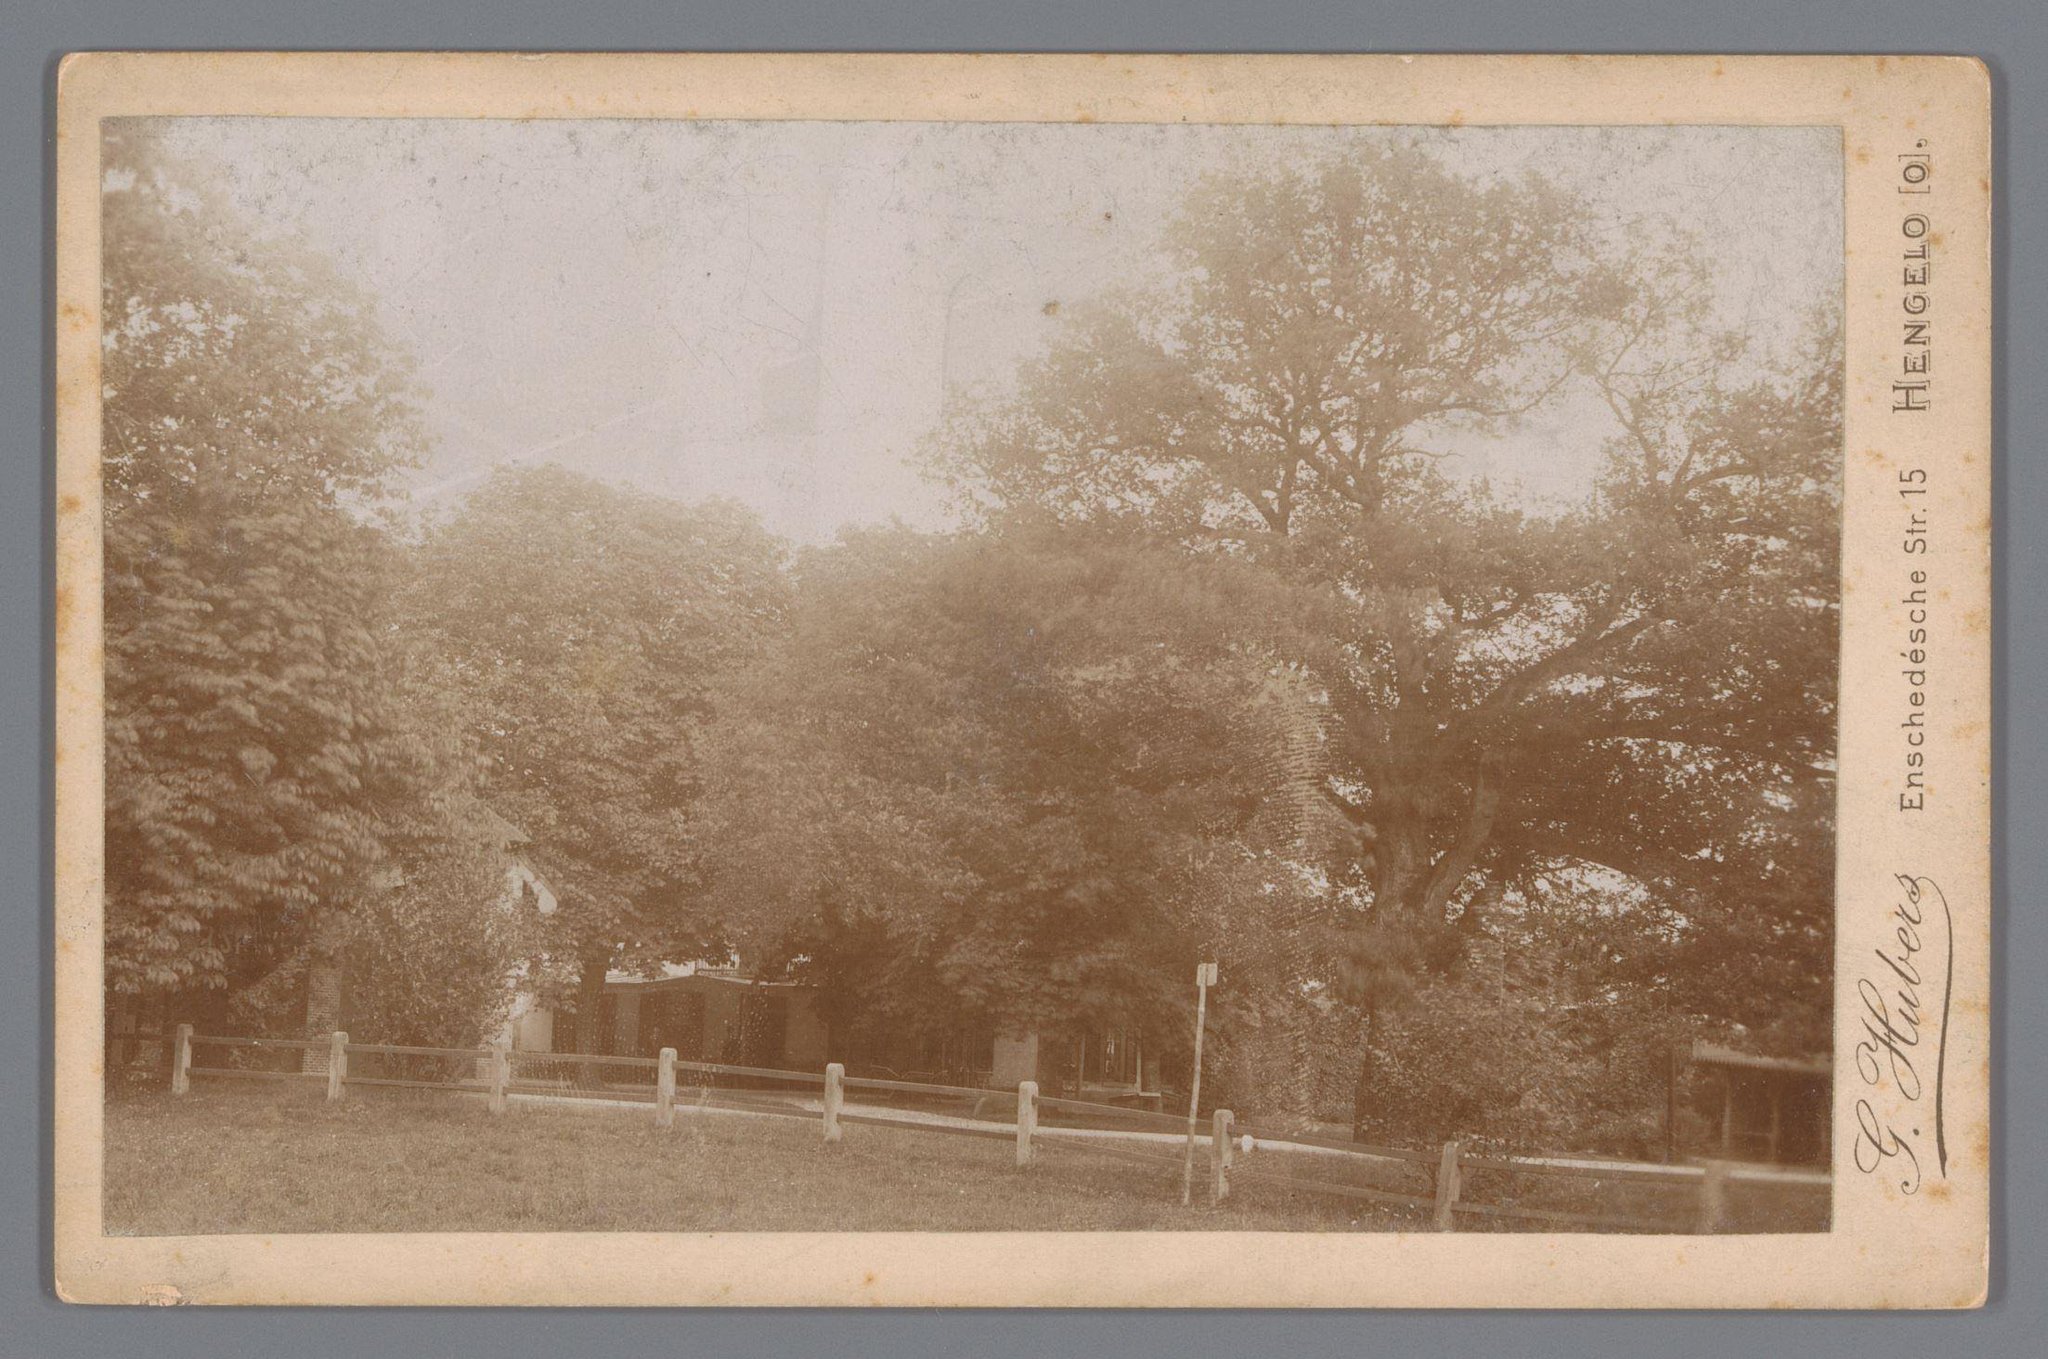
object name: photograph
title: Gezicht op een park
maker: gerrit hubers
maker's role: fotograaf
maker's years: 1863-1927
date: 1894-1927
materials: cardboard, photographic support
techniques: collodion silver print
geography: netherlands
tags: park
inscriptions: annotation: ‘G. Hubers/ Enschedésche Str. 15/ Hengelo [O].’, retailer's mark: ‘Boekhandel-Binderij/ E. Broekhuis/ Hengelo (O.)’, number: ‘201’